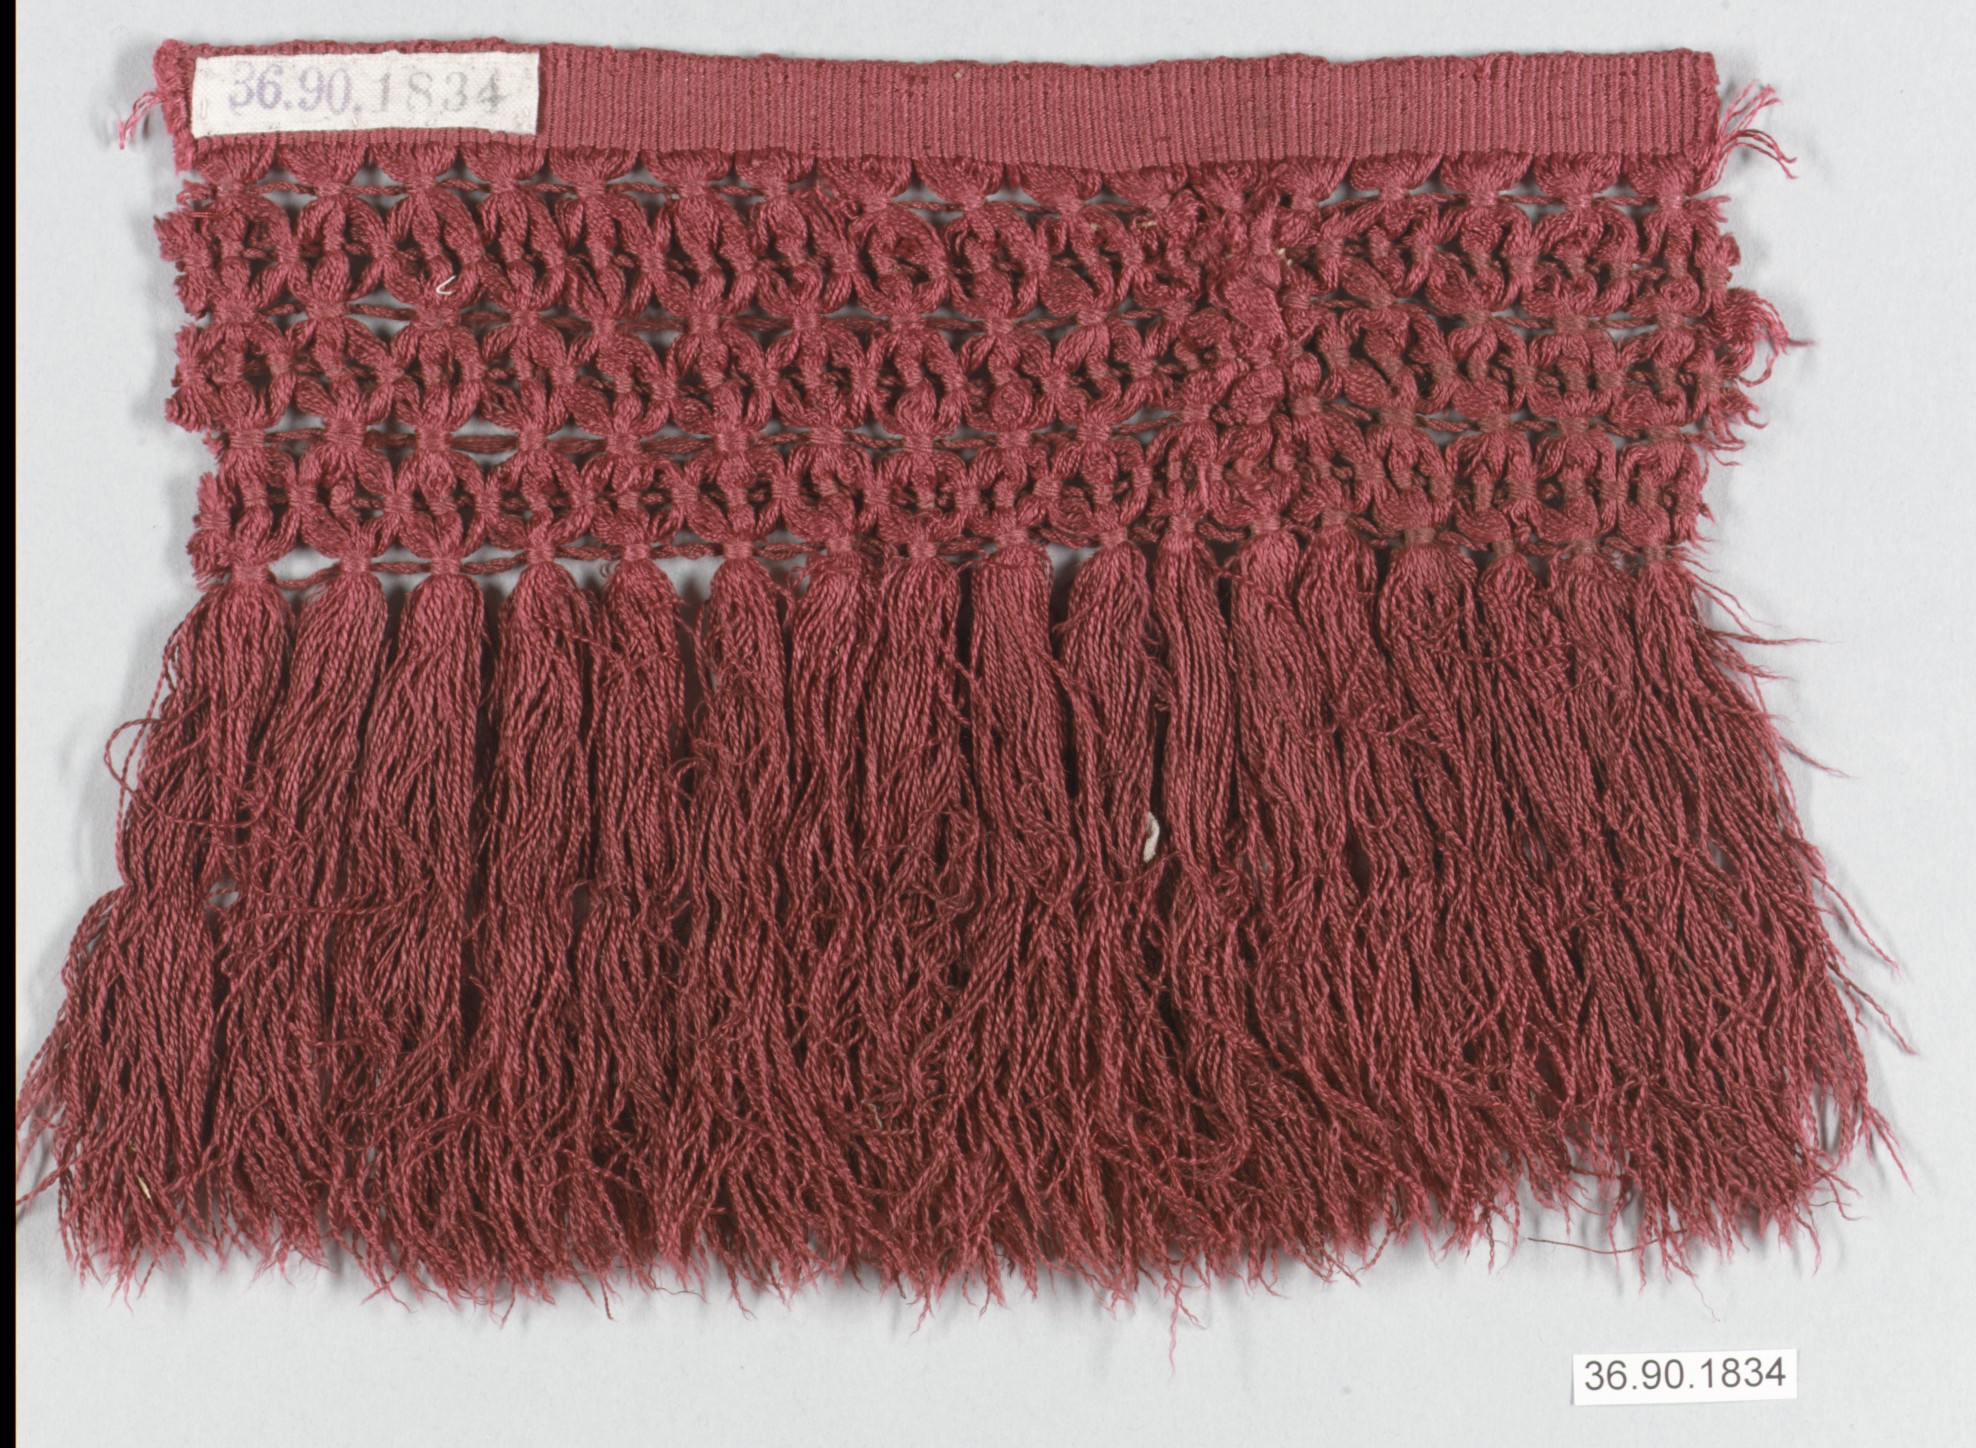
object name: fringe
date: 1801-1833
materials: silk